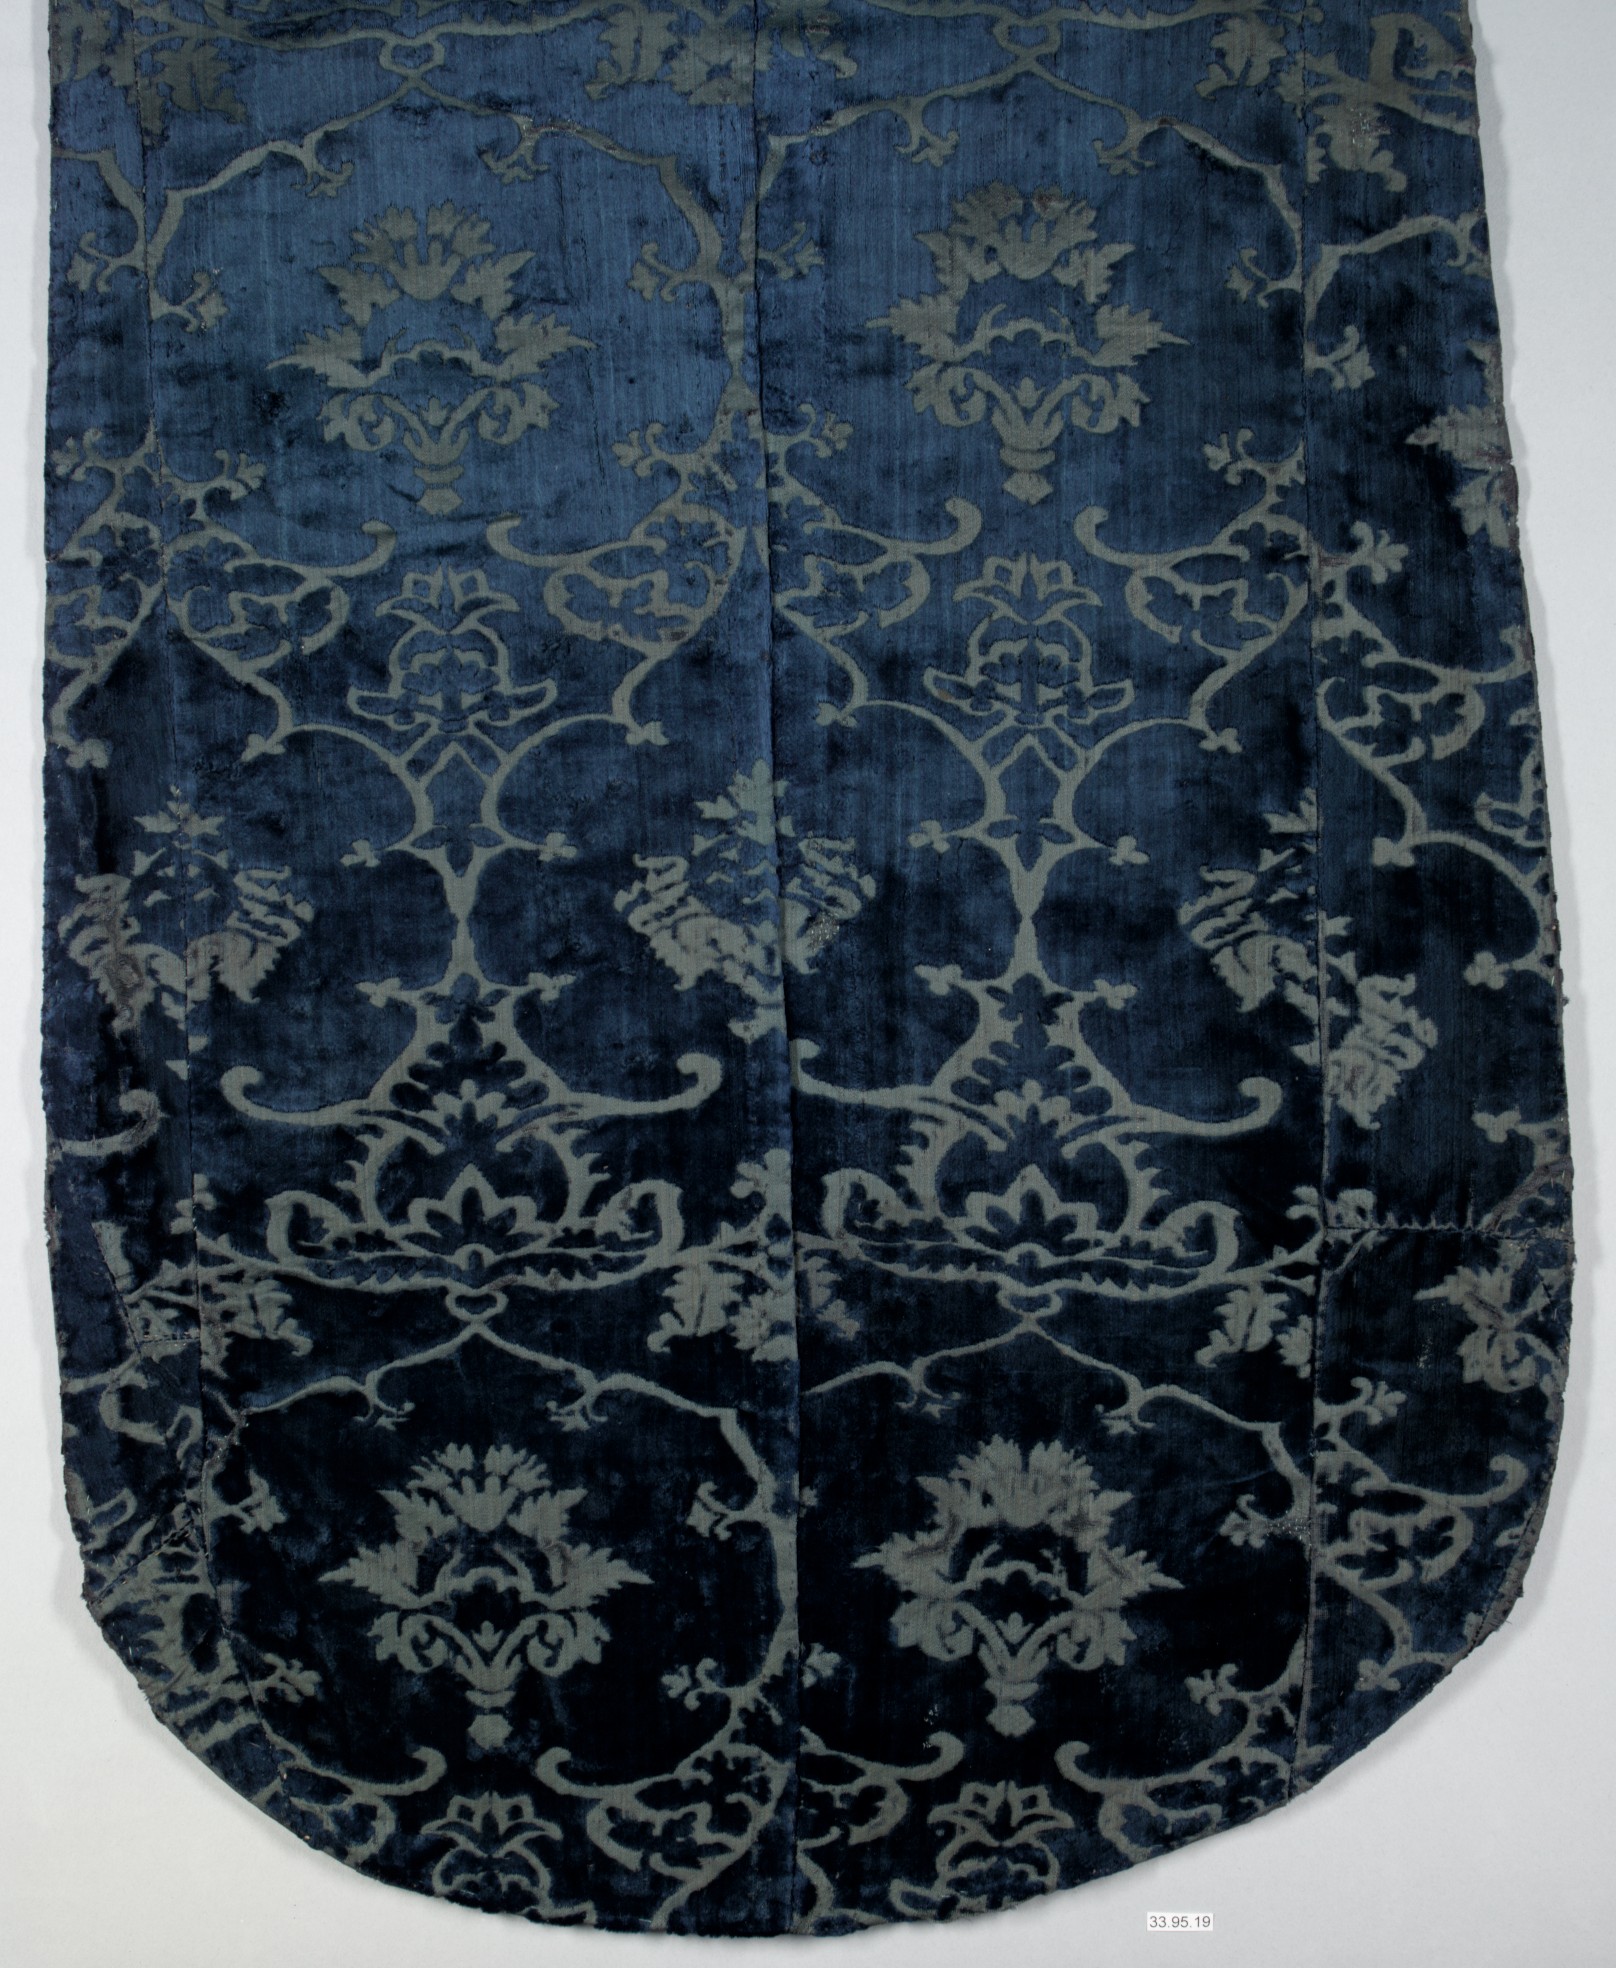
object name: piece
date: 1401-1600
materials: silk